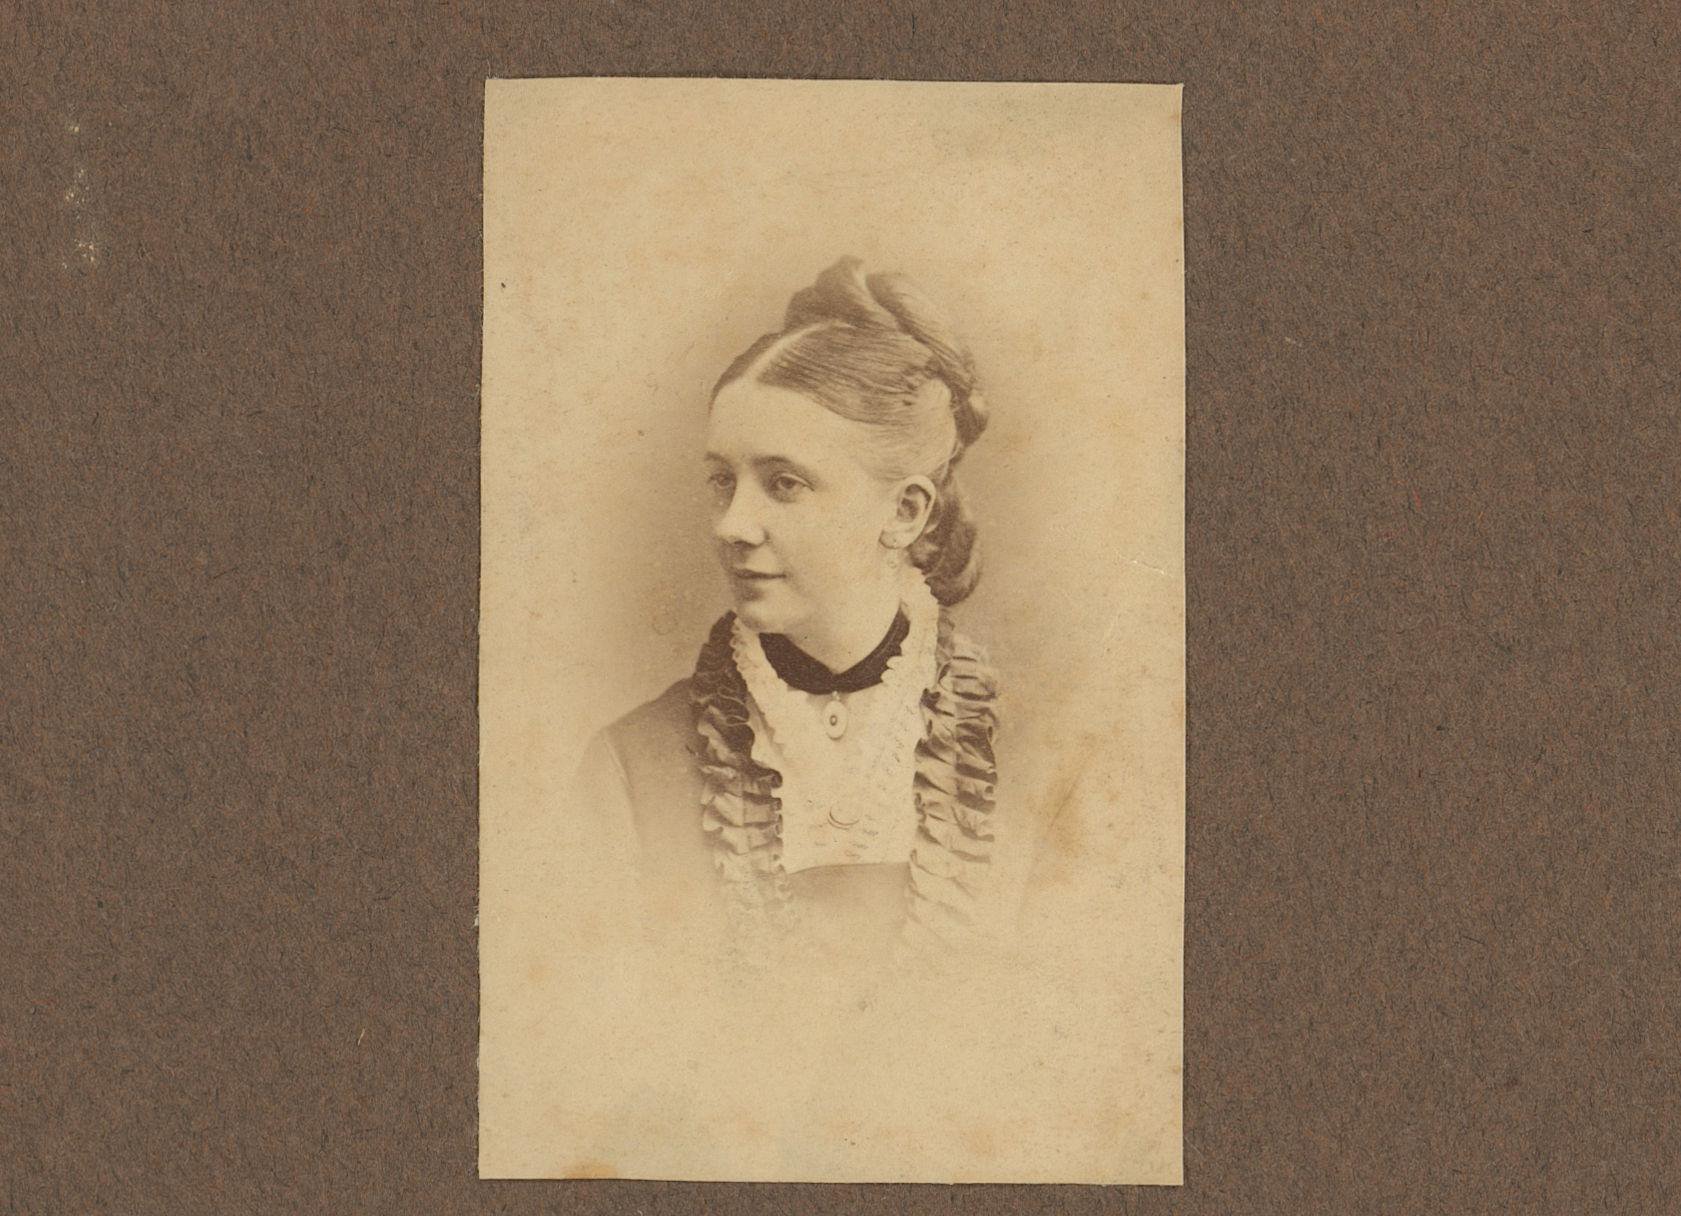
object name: photograph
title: Portret van jonge vrouw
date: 1870-1920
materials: photographic support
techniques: photography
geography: amsterdam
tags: netherlands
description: Foto op bruin albumblad 33 van familiealbum van Alphons Diepenbrock.